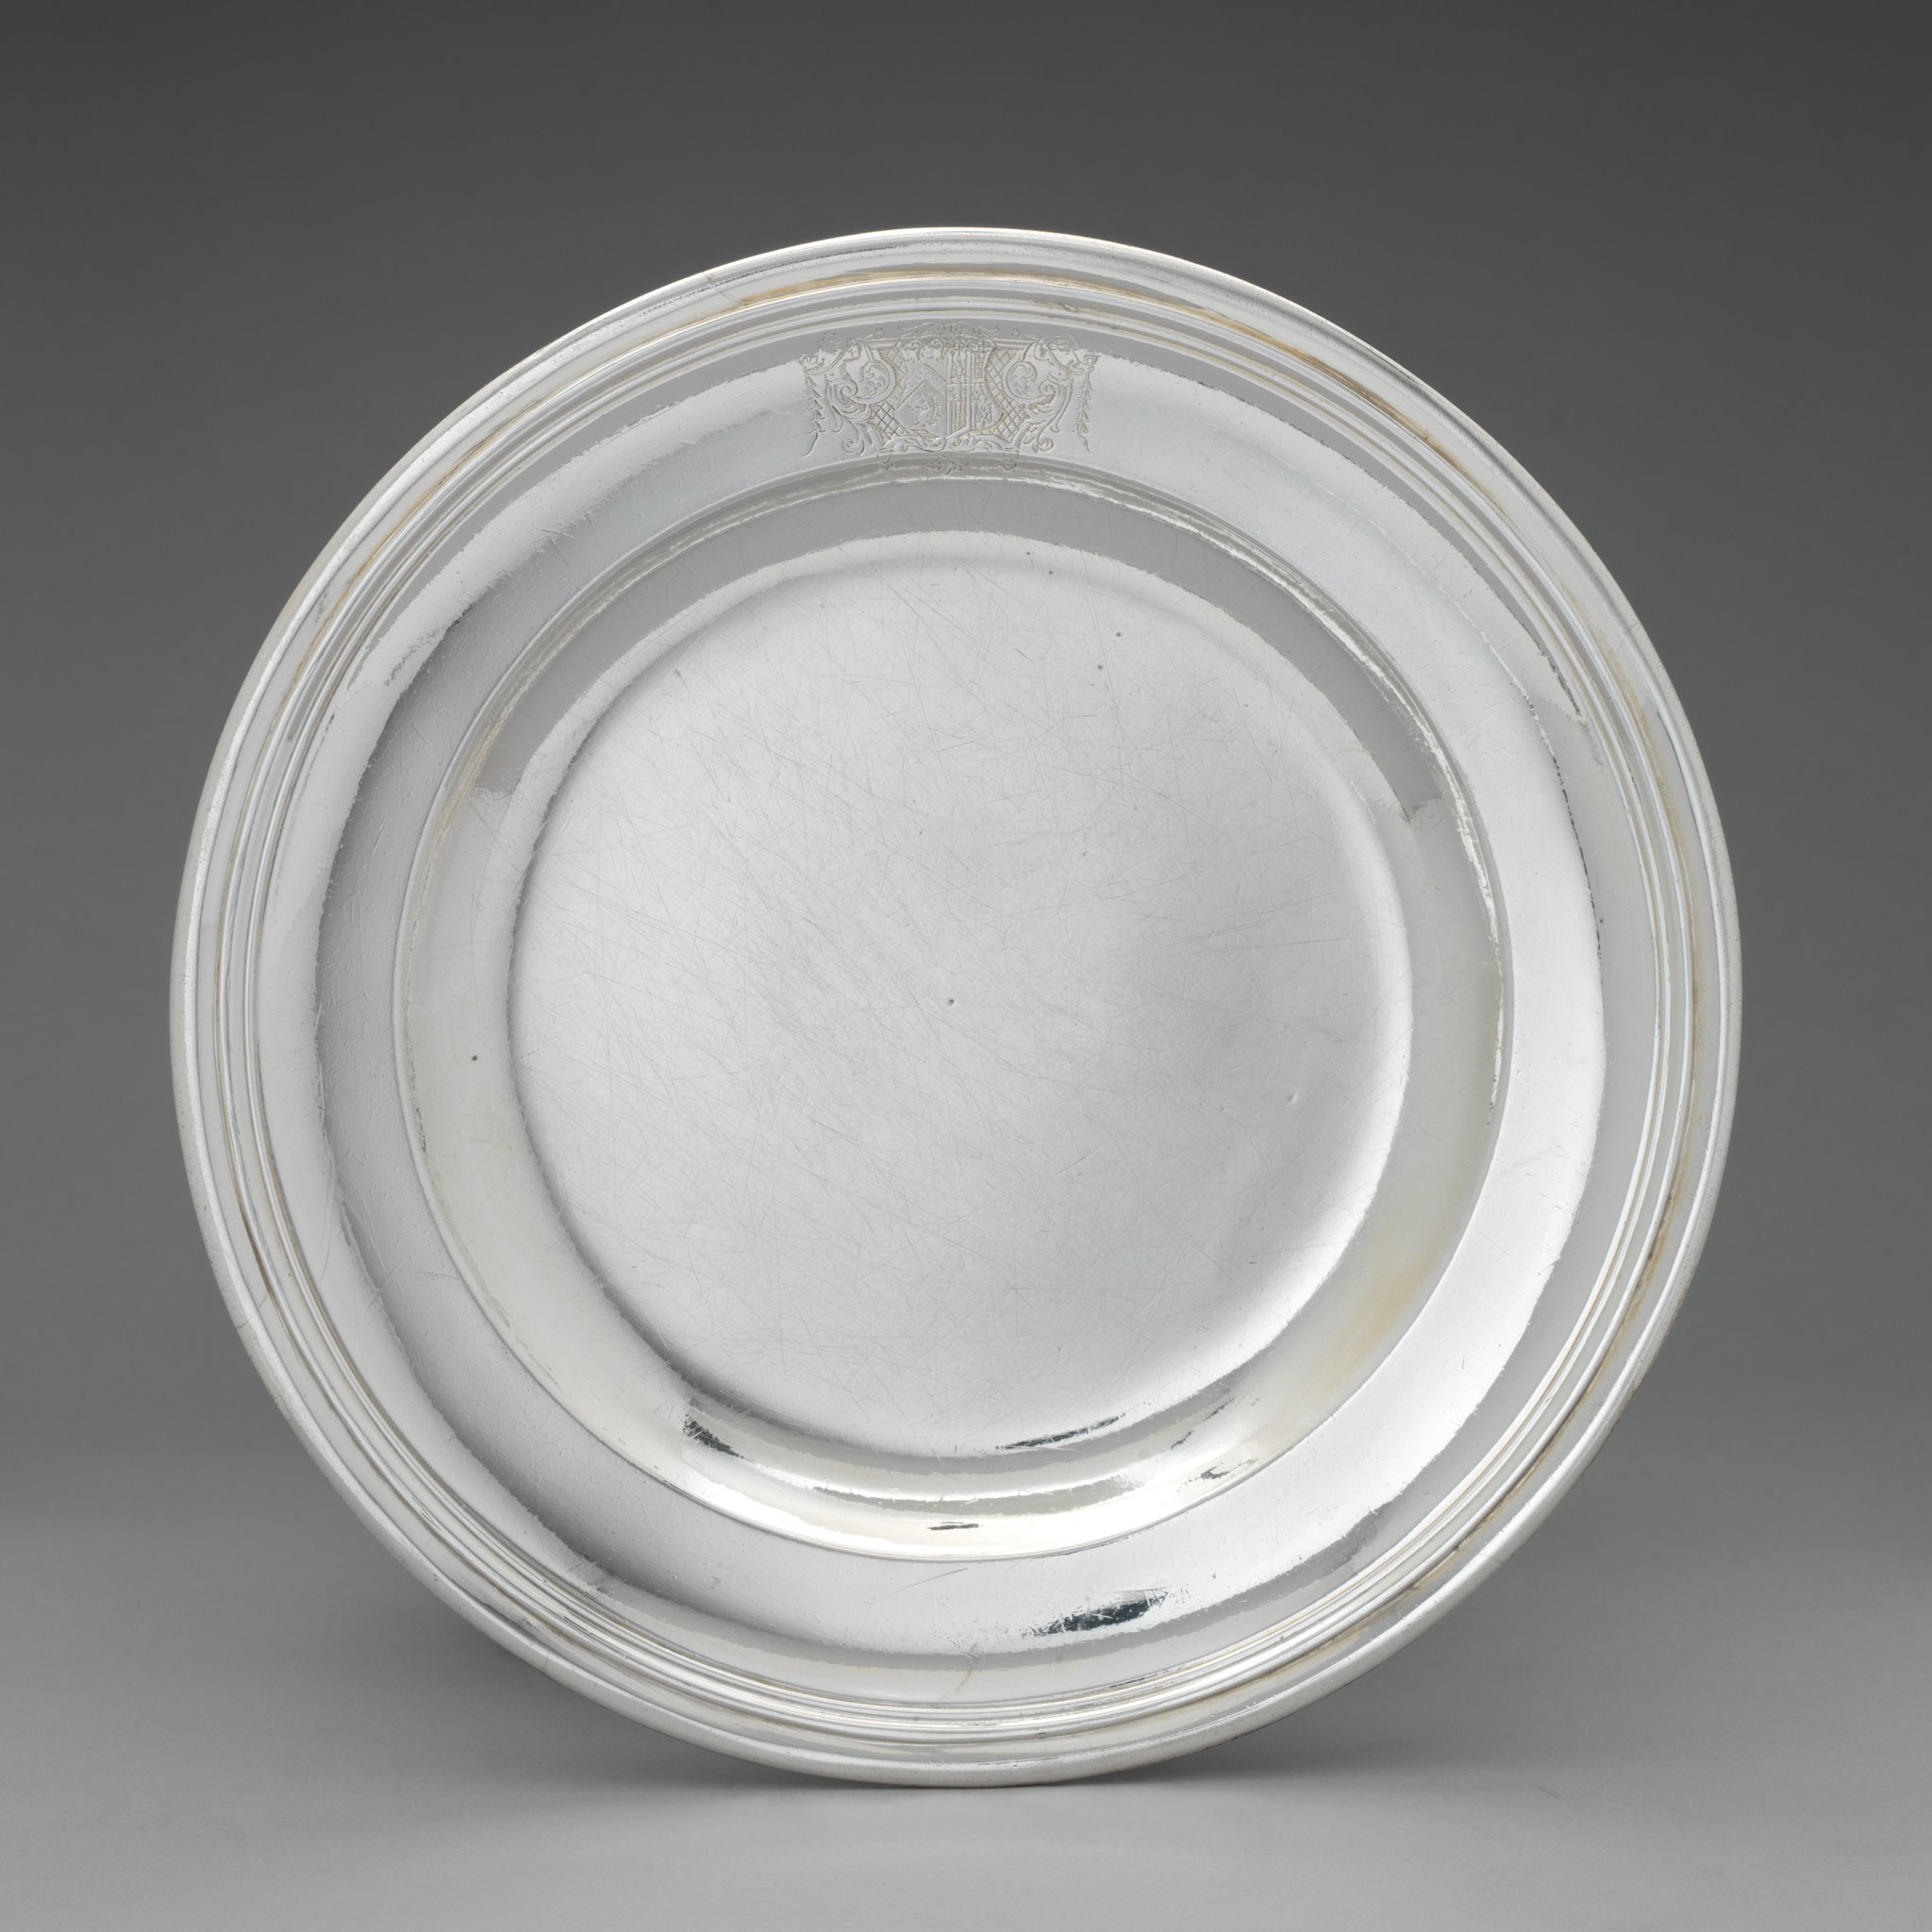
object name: plate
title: Plate (one of a set of twelve)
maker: thomas farren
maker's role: maker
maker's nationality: british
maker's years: 1703-1743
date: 1715-1716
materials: silver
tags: coat of arms